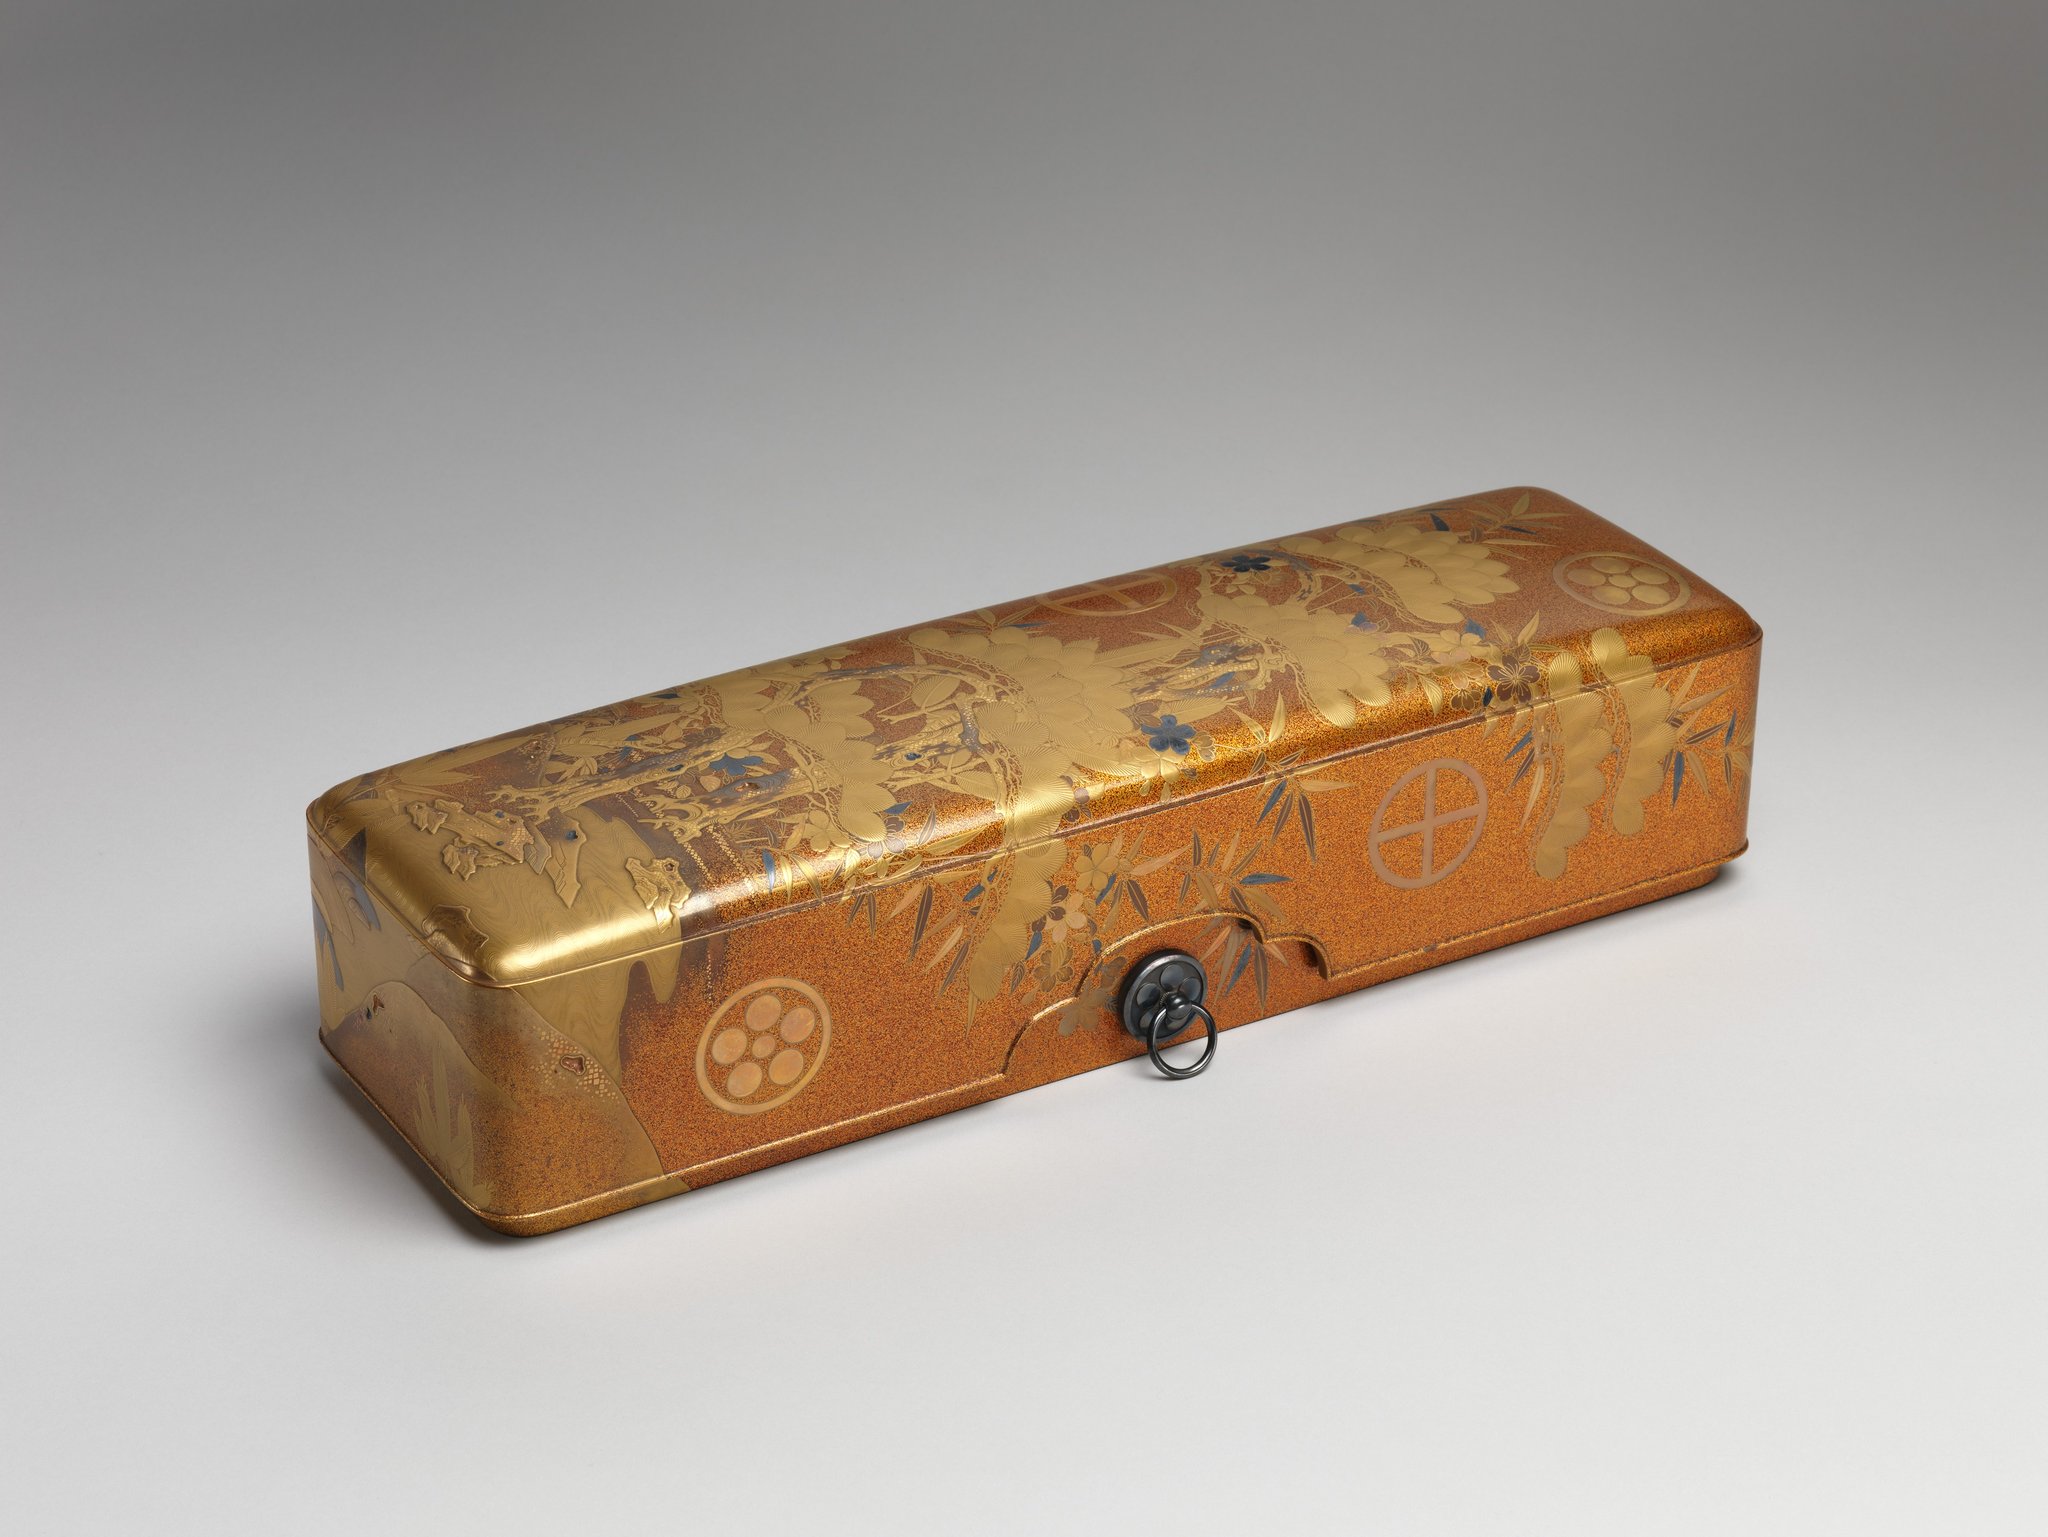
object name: dispatch box with cover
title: Box with Design of Pine, Bamboo, and Cherry Blossom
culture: japanese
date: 1801-1900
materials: gold, lacquer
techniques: maki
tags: flowers,bamboo